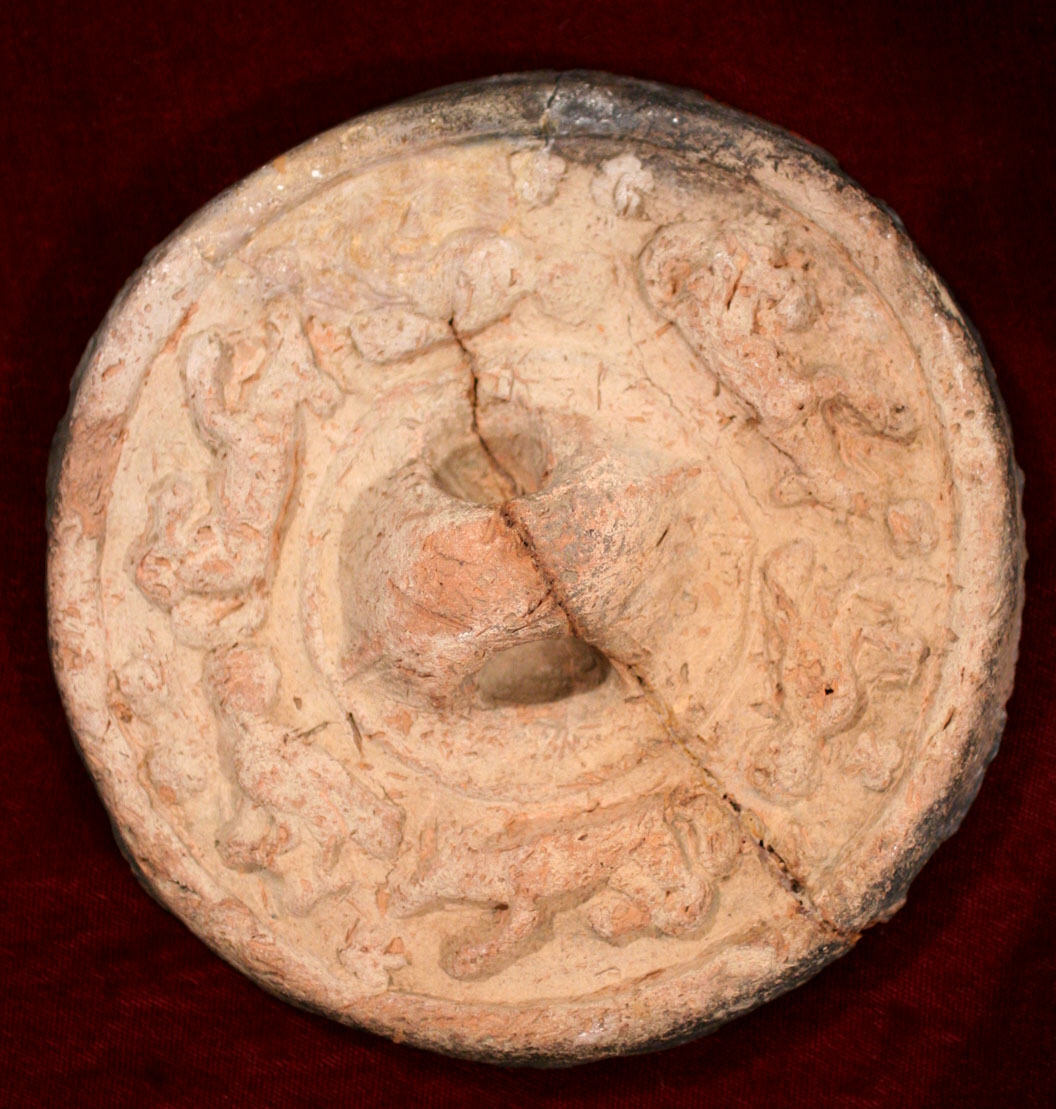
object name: pod lid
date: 801-1000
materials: earthenware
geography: iran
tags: animals